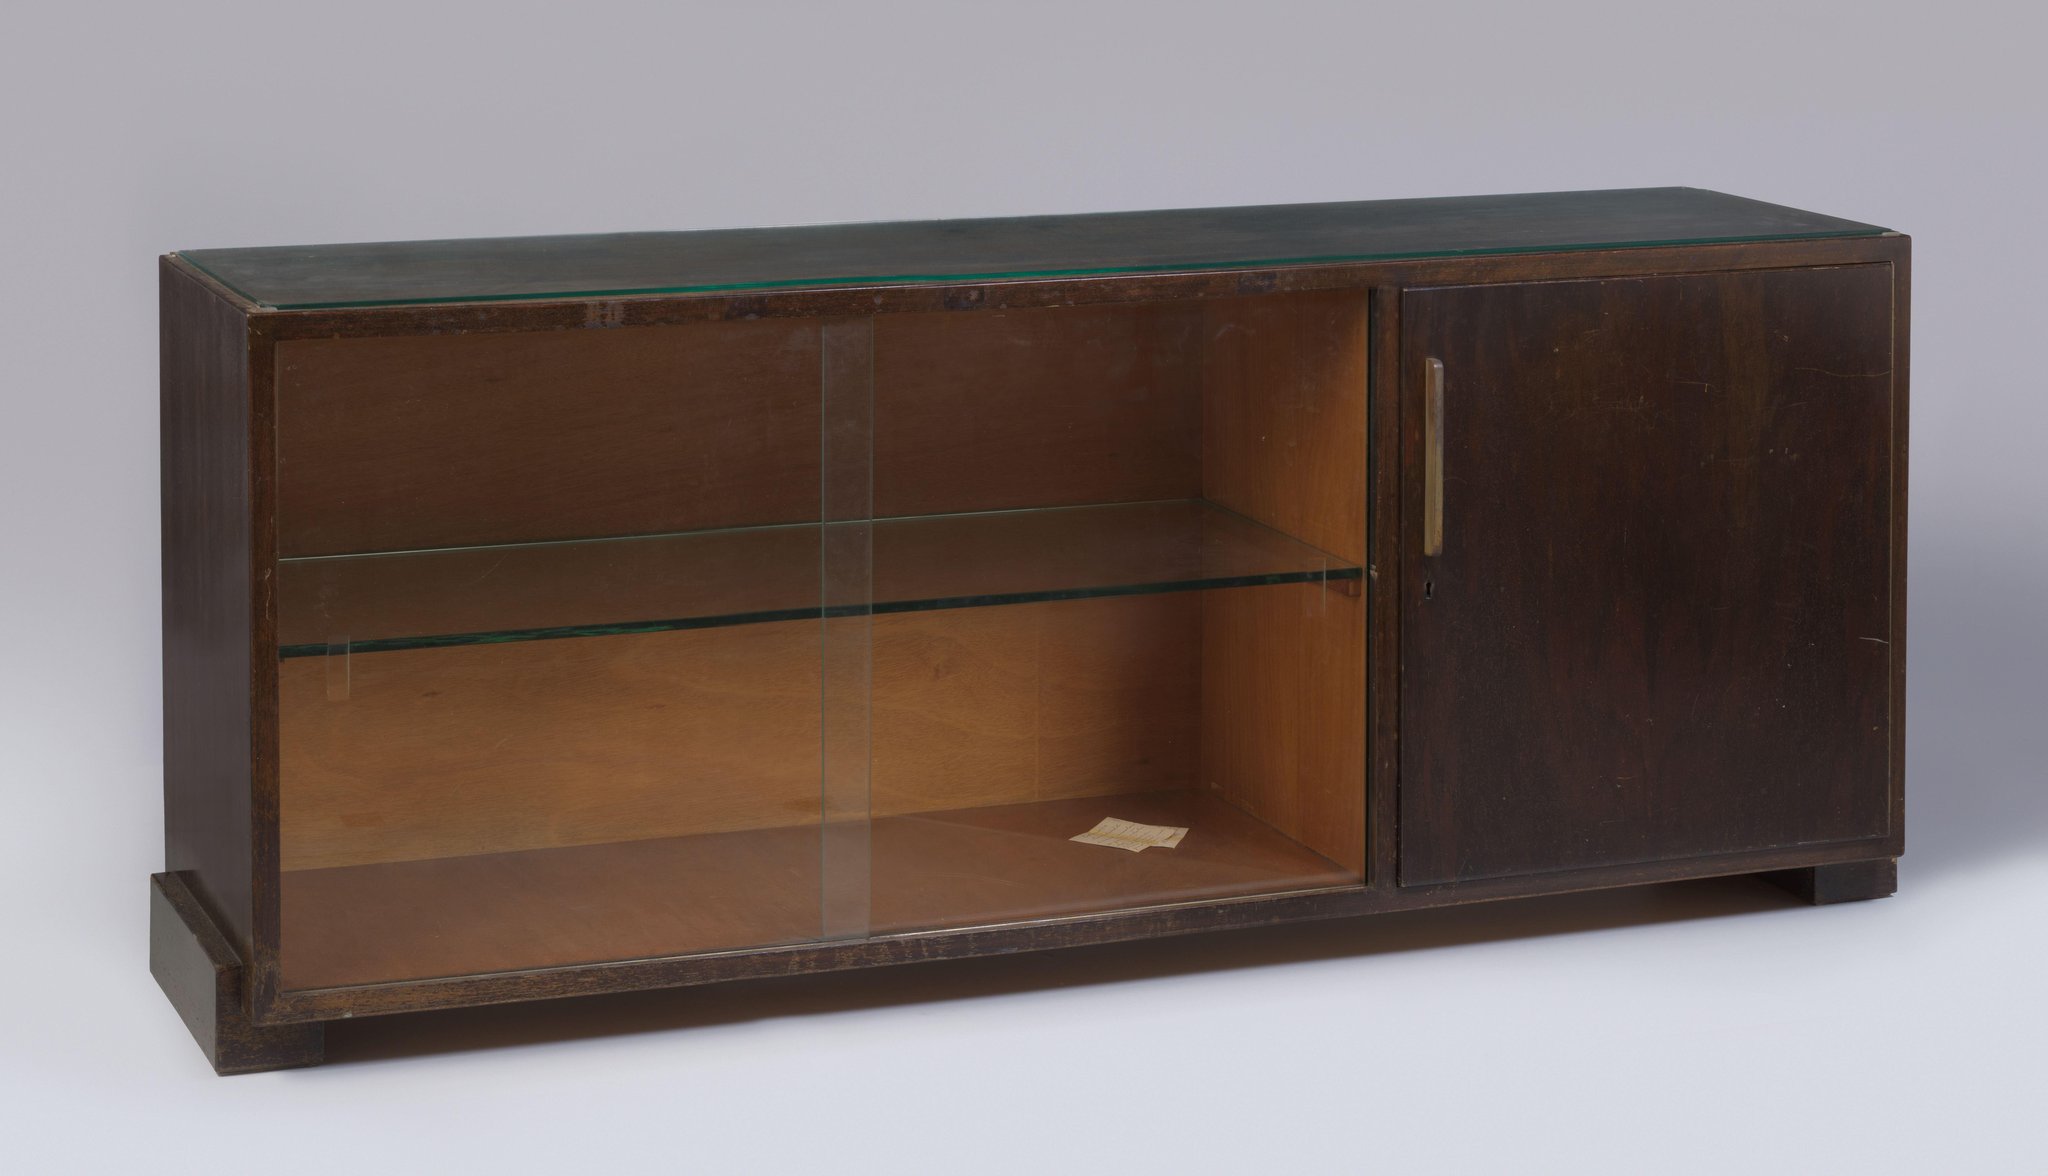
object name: theemeubel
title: Theemeubel met schuifvensters aan de linkerzijde en een deur aan de rechterzijde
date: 1933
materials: brass, wood, glass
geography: the hague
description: Theemeubel van multiplex met fineer van coromandelhout rustend op twee rechthoekige regels waar de zijkanten zijn ingelaten. Het brede rechthoekige theemeubel wordt aan de linkerzijde afgesloten door twee glazen schuifvensters met ingeslepen handgrepen en aan de rechterzijde door een deur met een sleutelgat en een verticaal geplaatste greep van messing. Op het meubel ligt een glazen dekplaat binnen vier hoeken van messing.